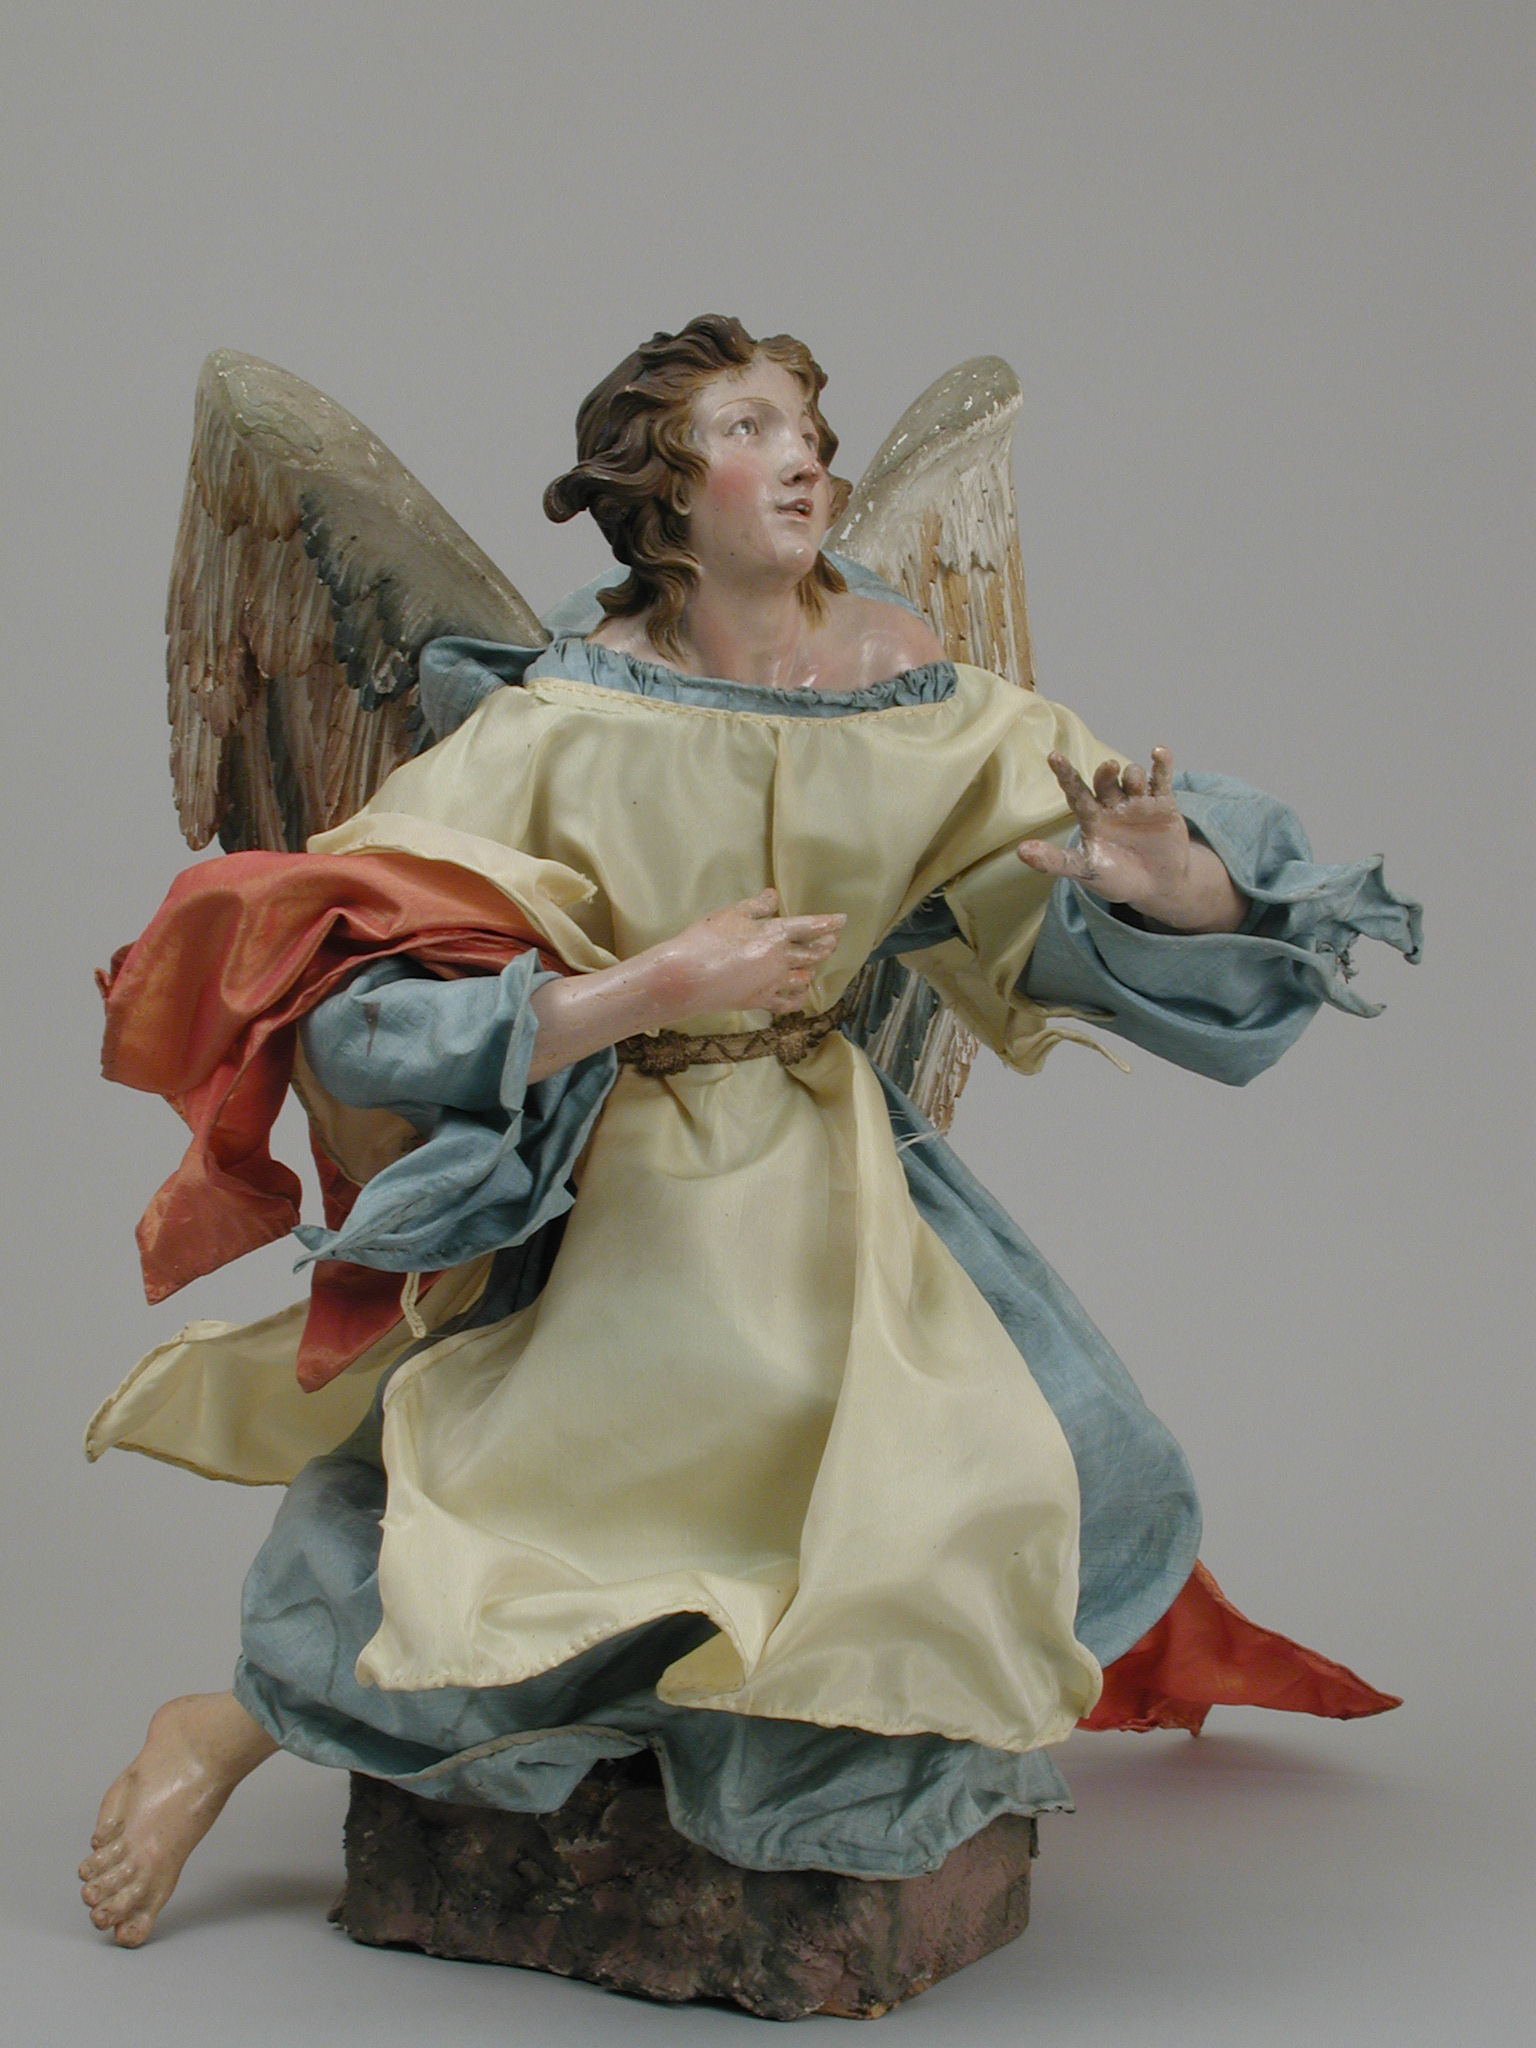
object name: crèche figure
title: Angel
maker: lorenzo mosca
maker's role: maker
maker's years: 1689-1789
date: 1751-1800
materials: terracotta, fiber, metal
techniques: polychrome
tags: angels